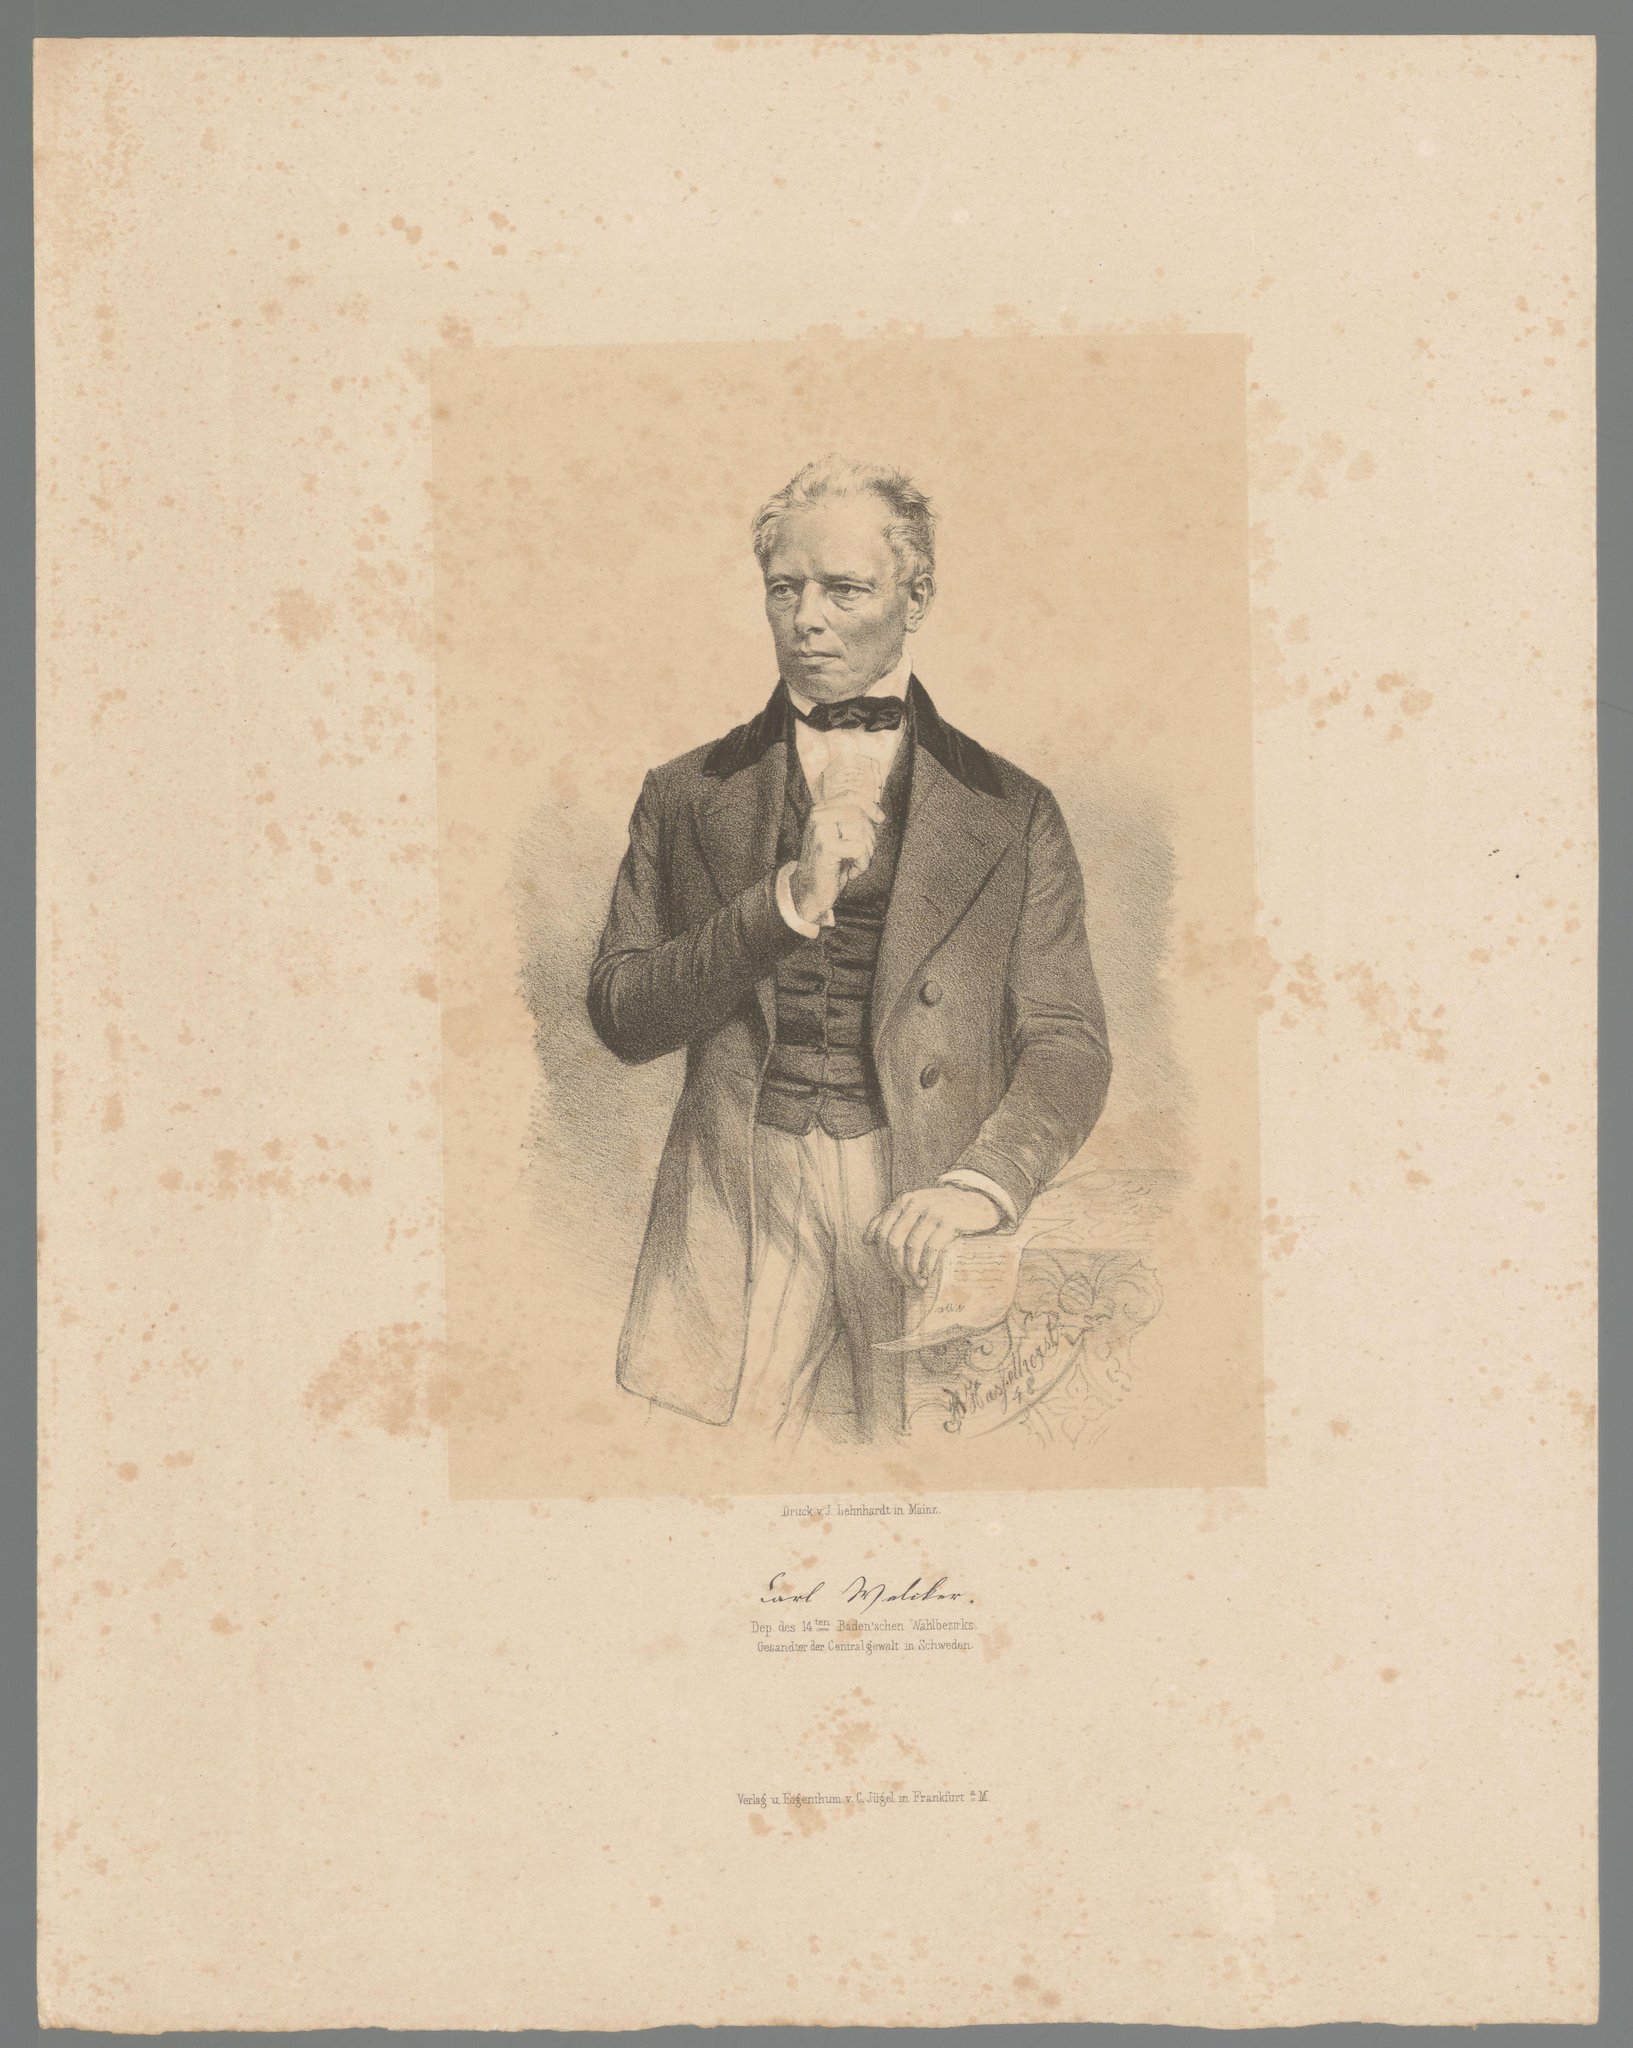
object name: print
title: Portret van Carl Theodor Welcker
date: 1848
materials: paper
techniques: lithograph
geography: mainz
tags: politician, historical persons, politician, e.g. party leader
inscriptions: date